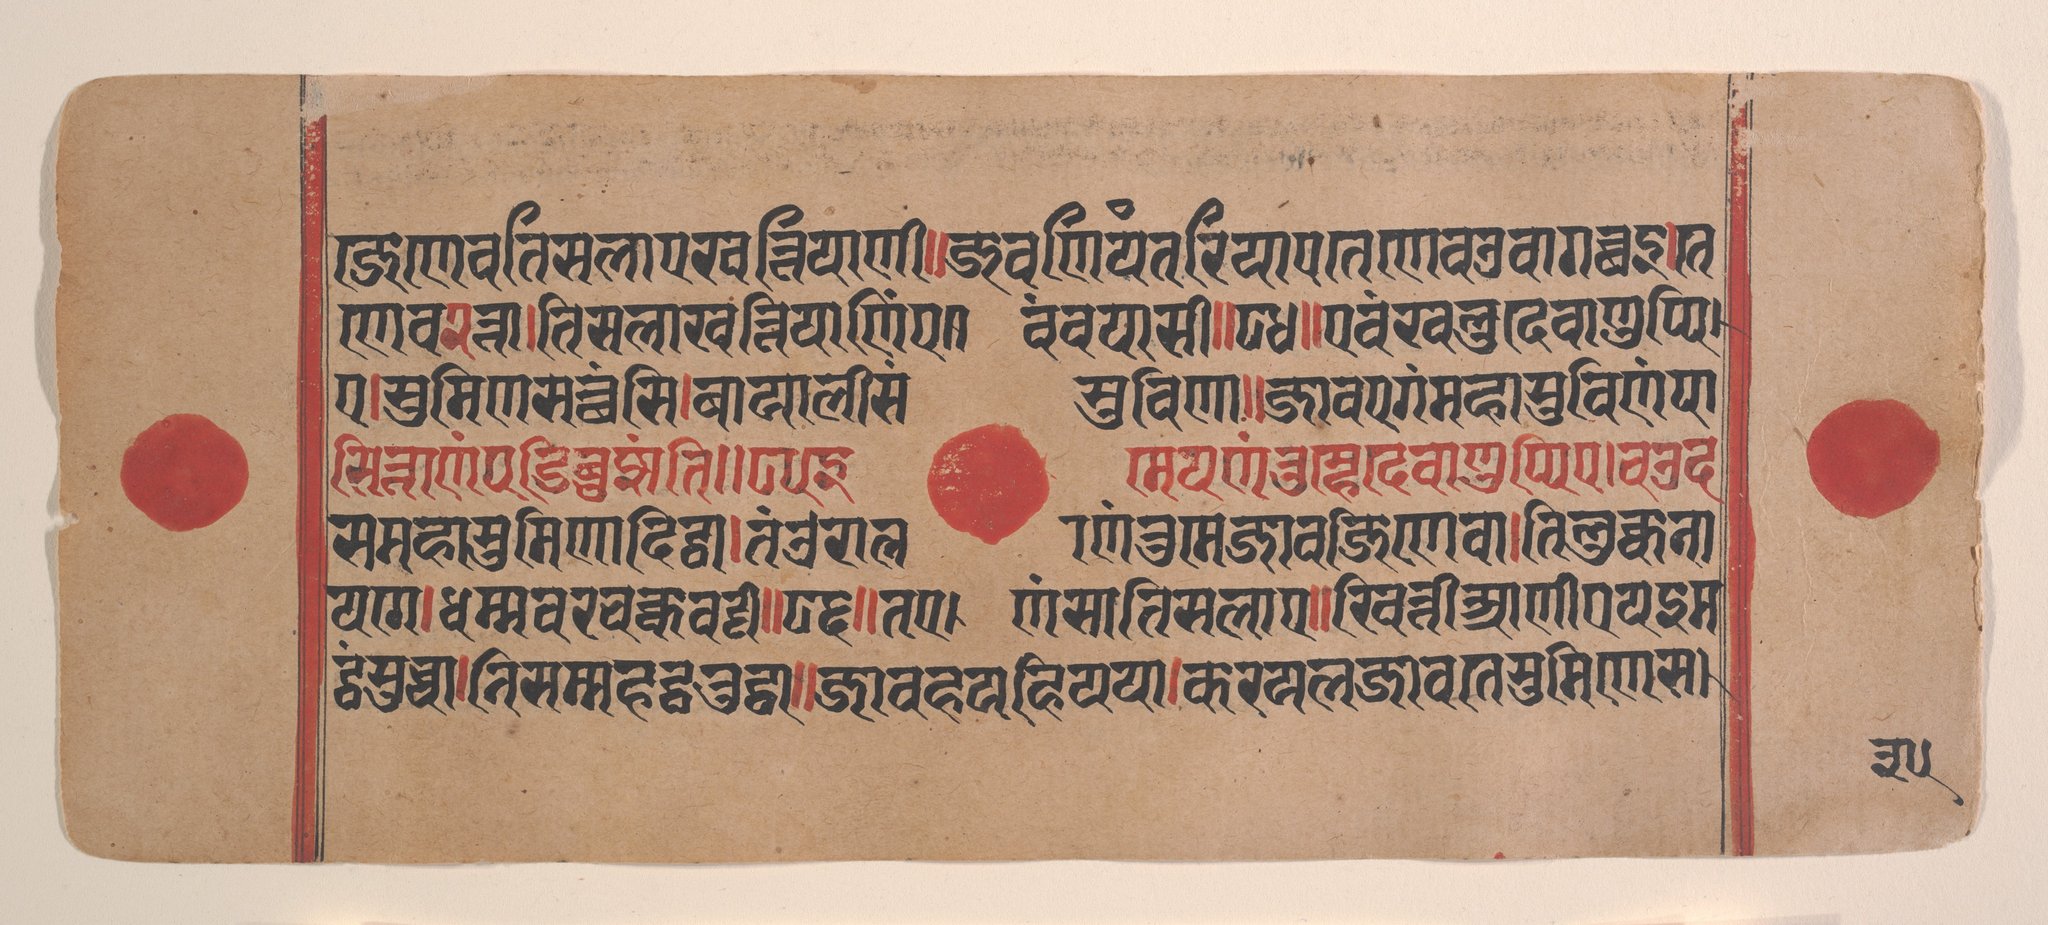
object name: folio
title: Page from a Dispersed Kalpa Sutra (Jain Book of Rituals)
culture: indian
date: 1401-1500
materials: gold, ink, paper, watercolor